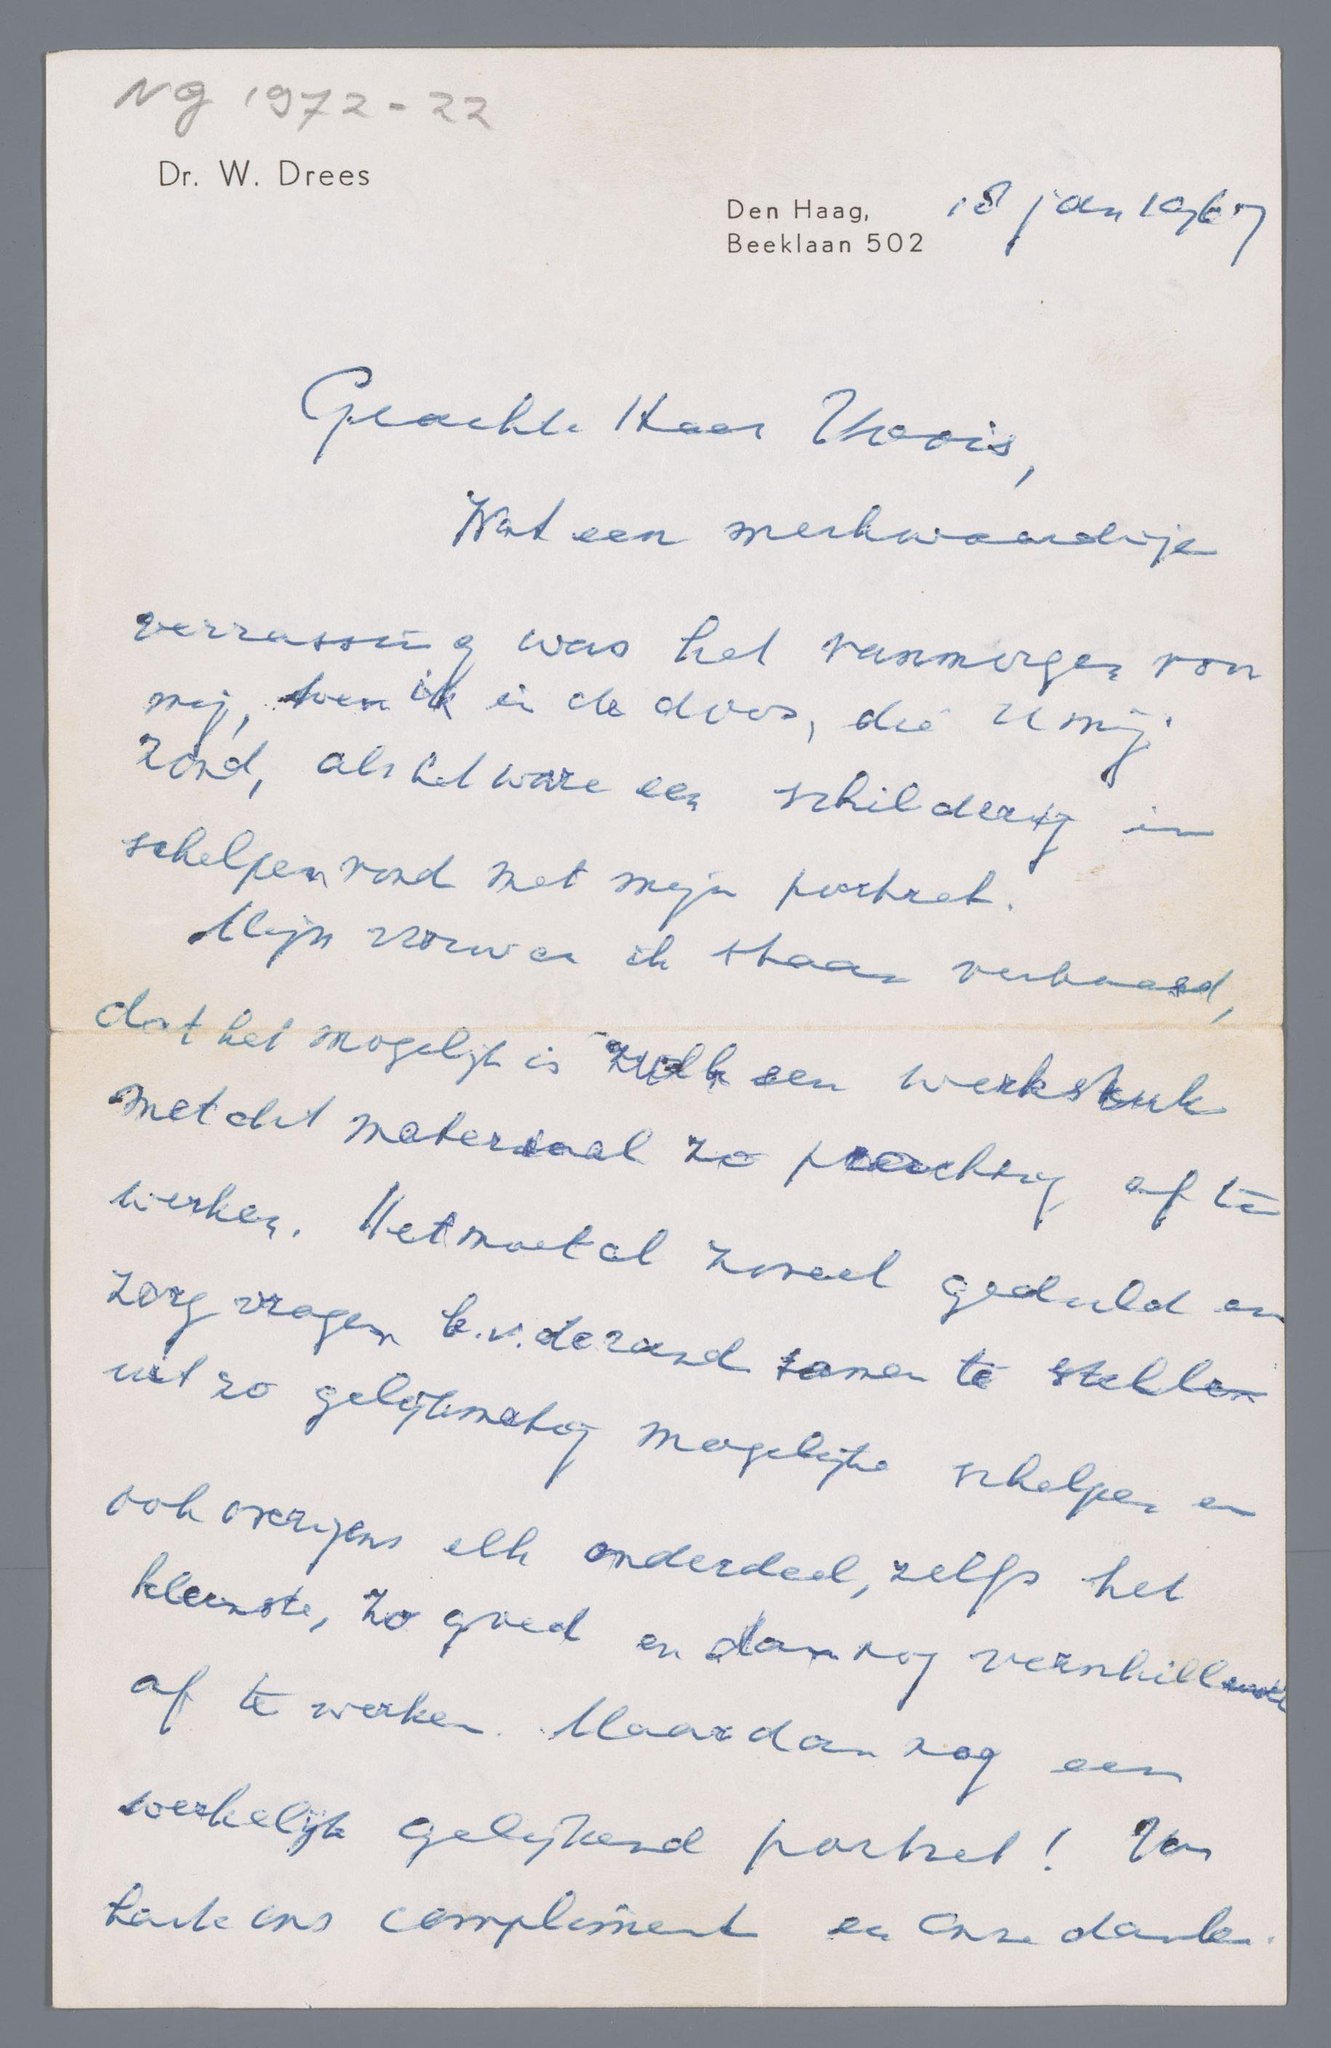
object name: letter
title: Brief van Willem Drees aan de schenker van het schelpenportret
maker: willem drees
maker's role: minister van sociale zaken, minister van staat, tweede kamerlid, fractievoorzitter, lid tweede kamer, minister-president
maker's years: 1886-1988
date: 1967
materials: paper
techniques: pen, writing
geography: the hague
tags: amsterdam, the hague, willem drees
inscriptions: date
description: In 1967 W. Drees presented several items to the Rijksmuseum on loan. In 1991 the Drees family changed this loan into a gift. In 2003 a number of objects were added from the estate of W. Drees.